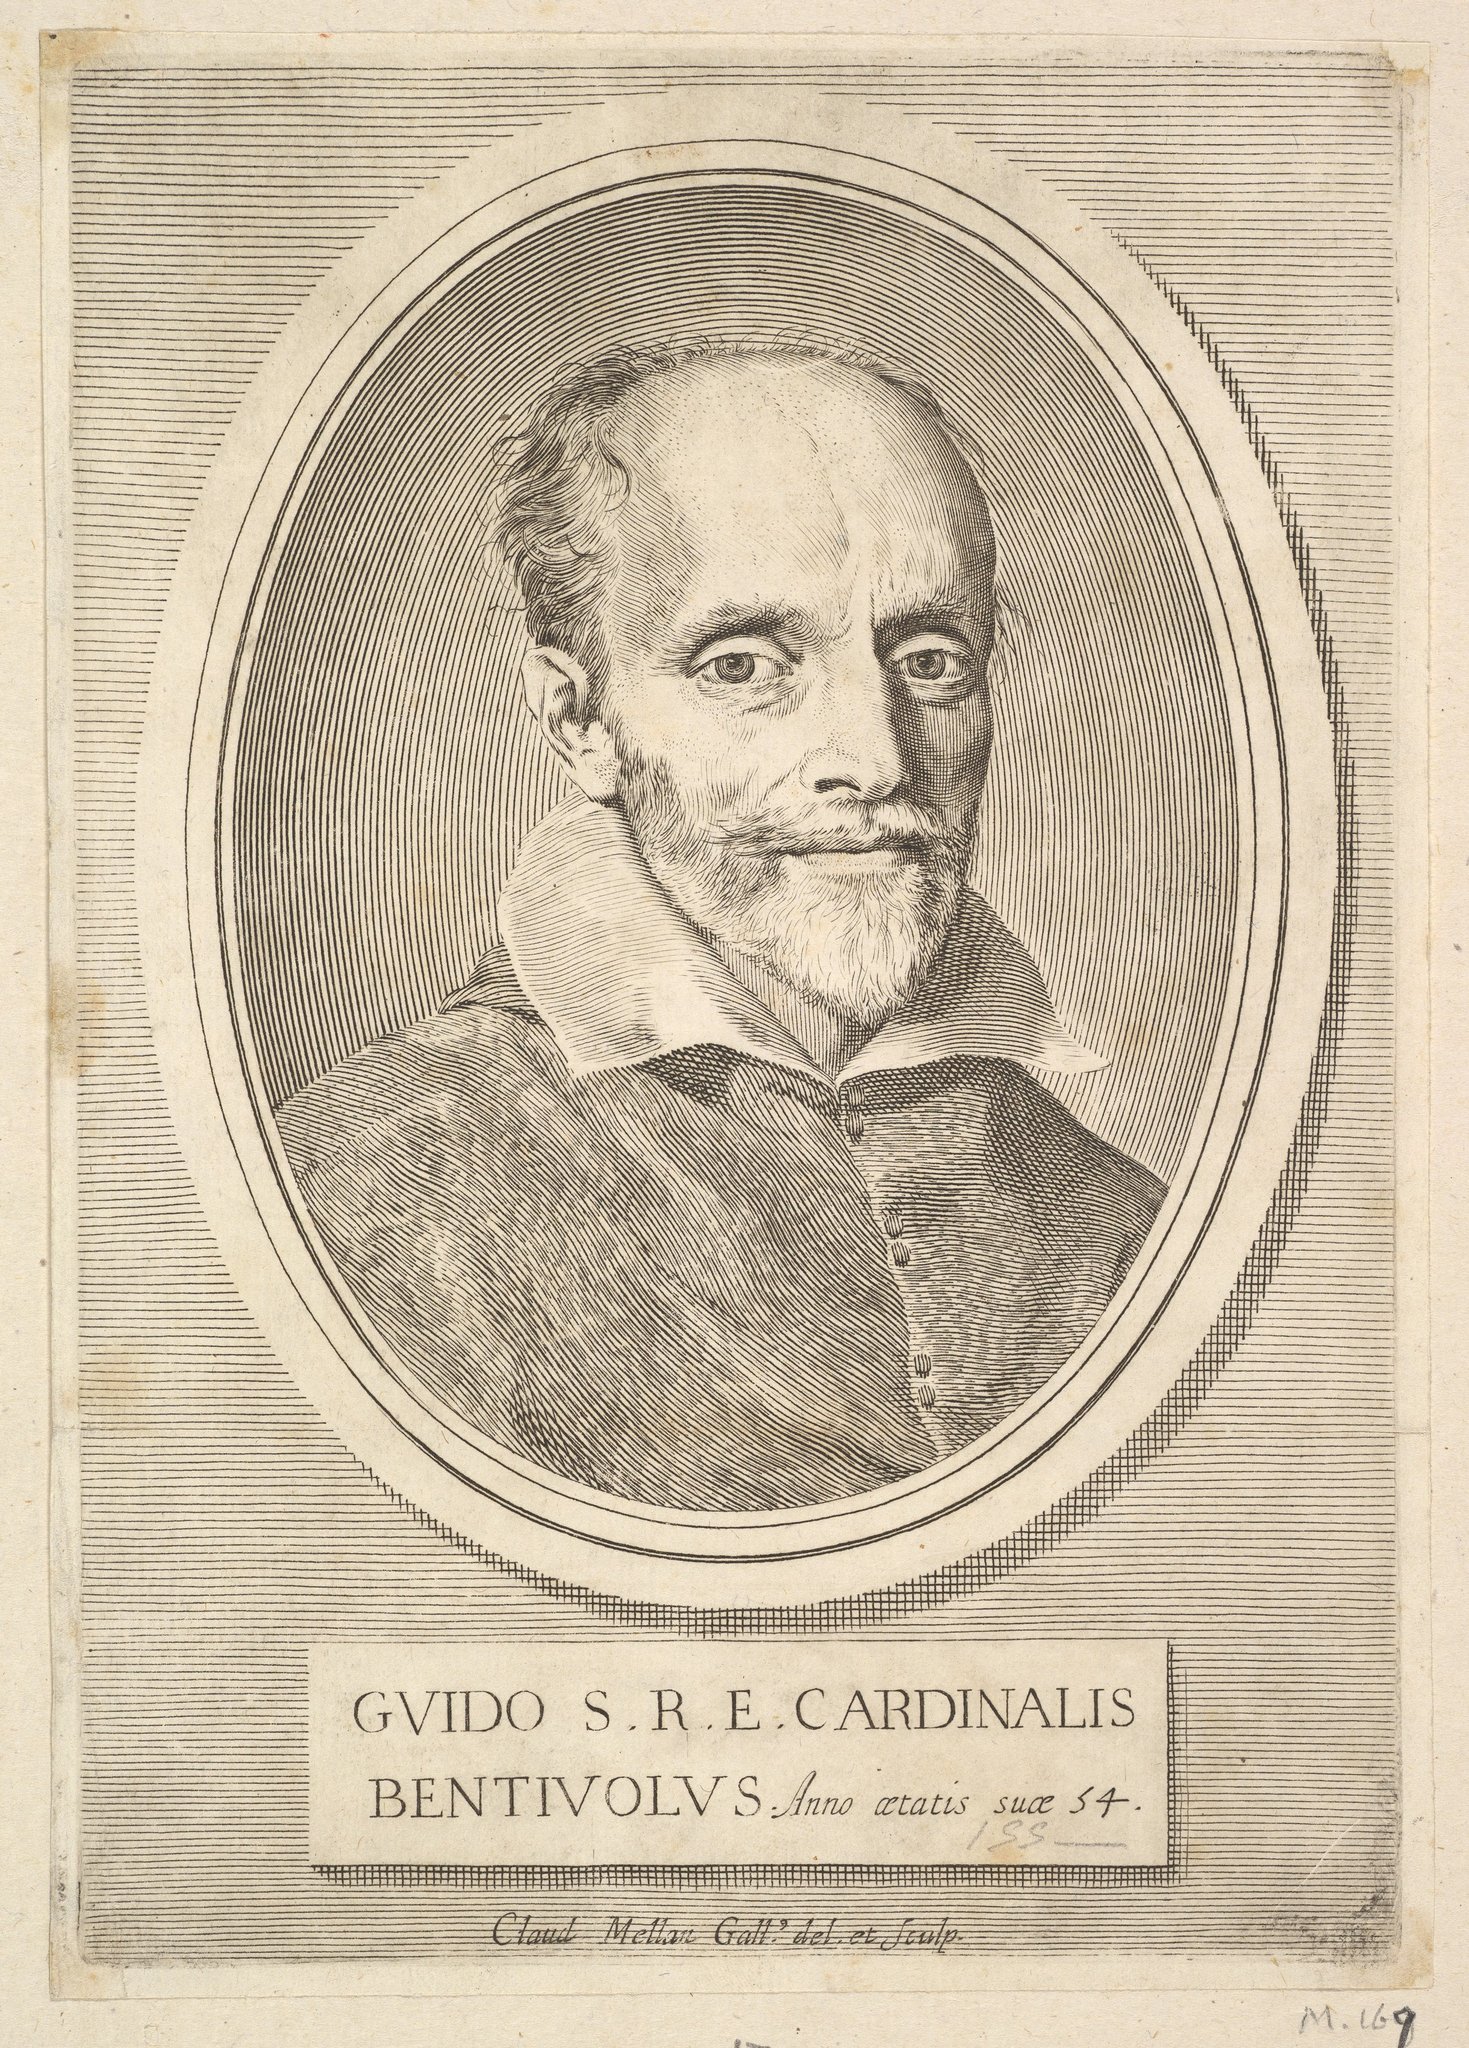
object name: print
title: Portrait of Cardinal Guido Bentivoglio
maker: claude mellan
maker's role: artist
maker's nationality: french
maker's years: 1598-1688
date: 1633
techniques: engraving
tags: men,portraits